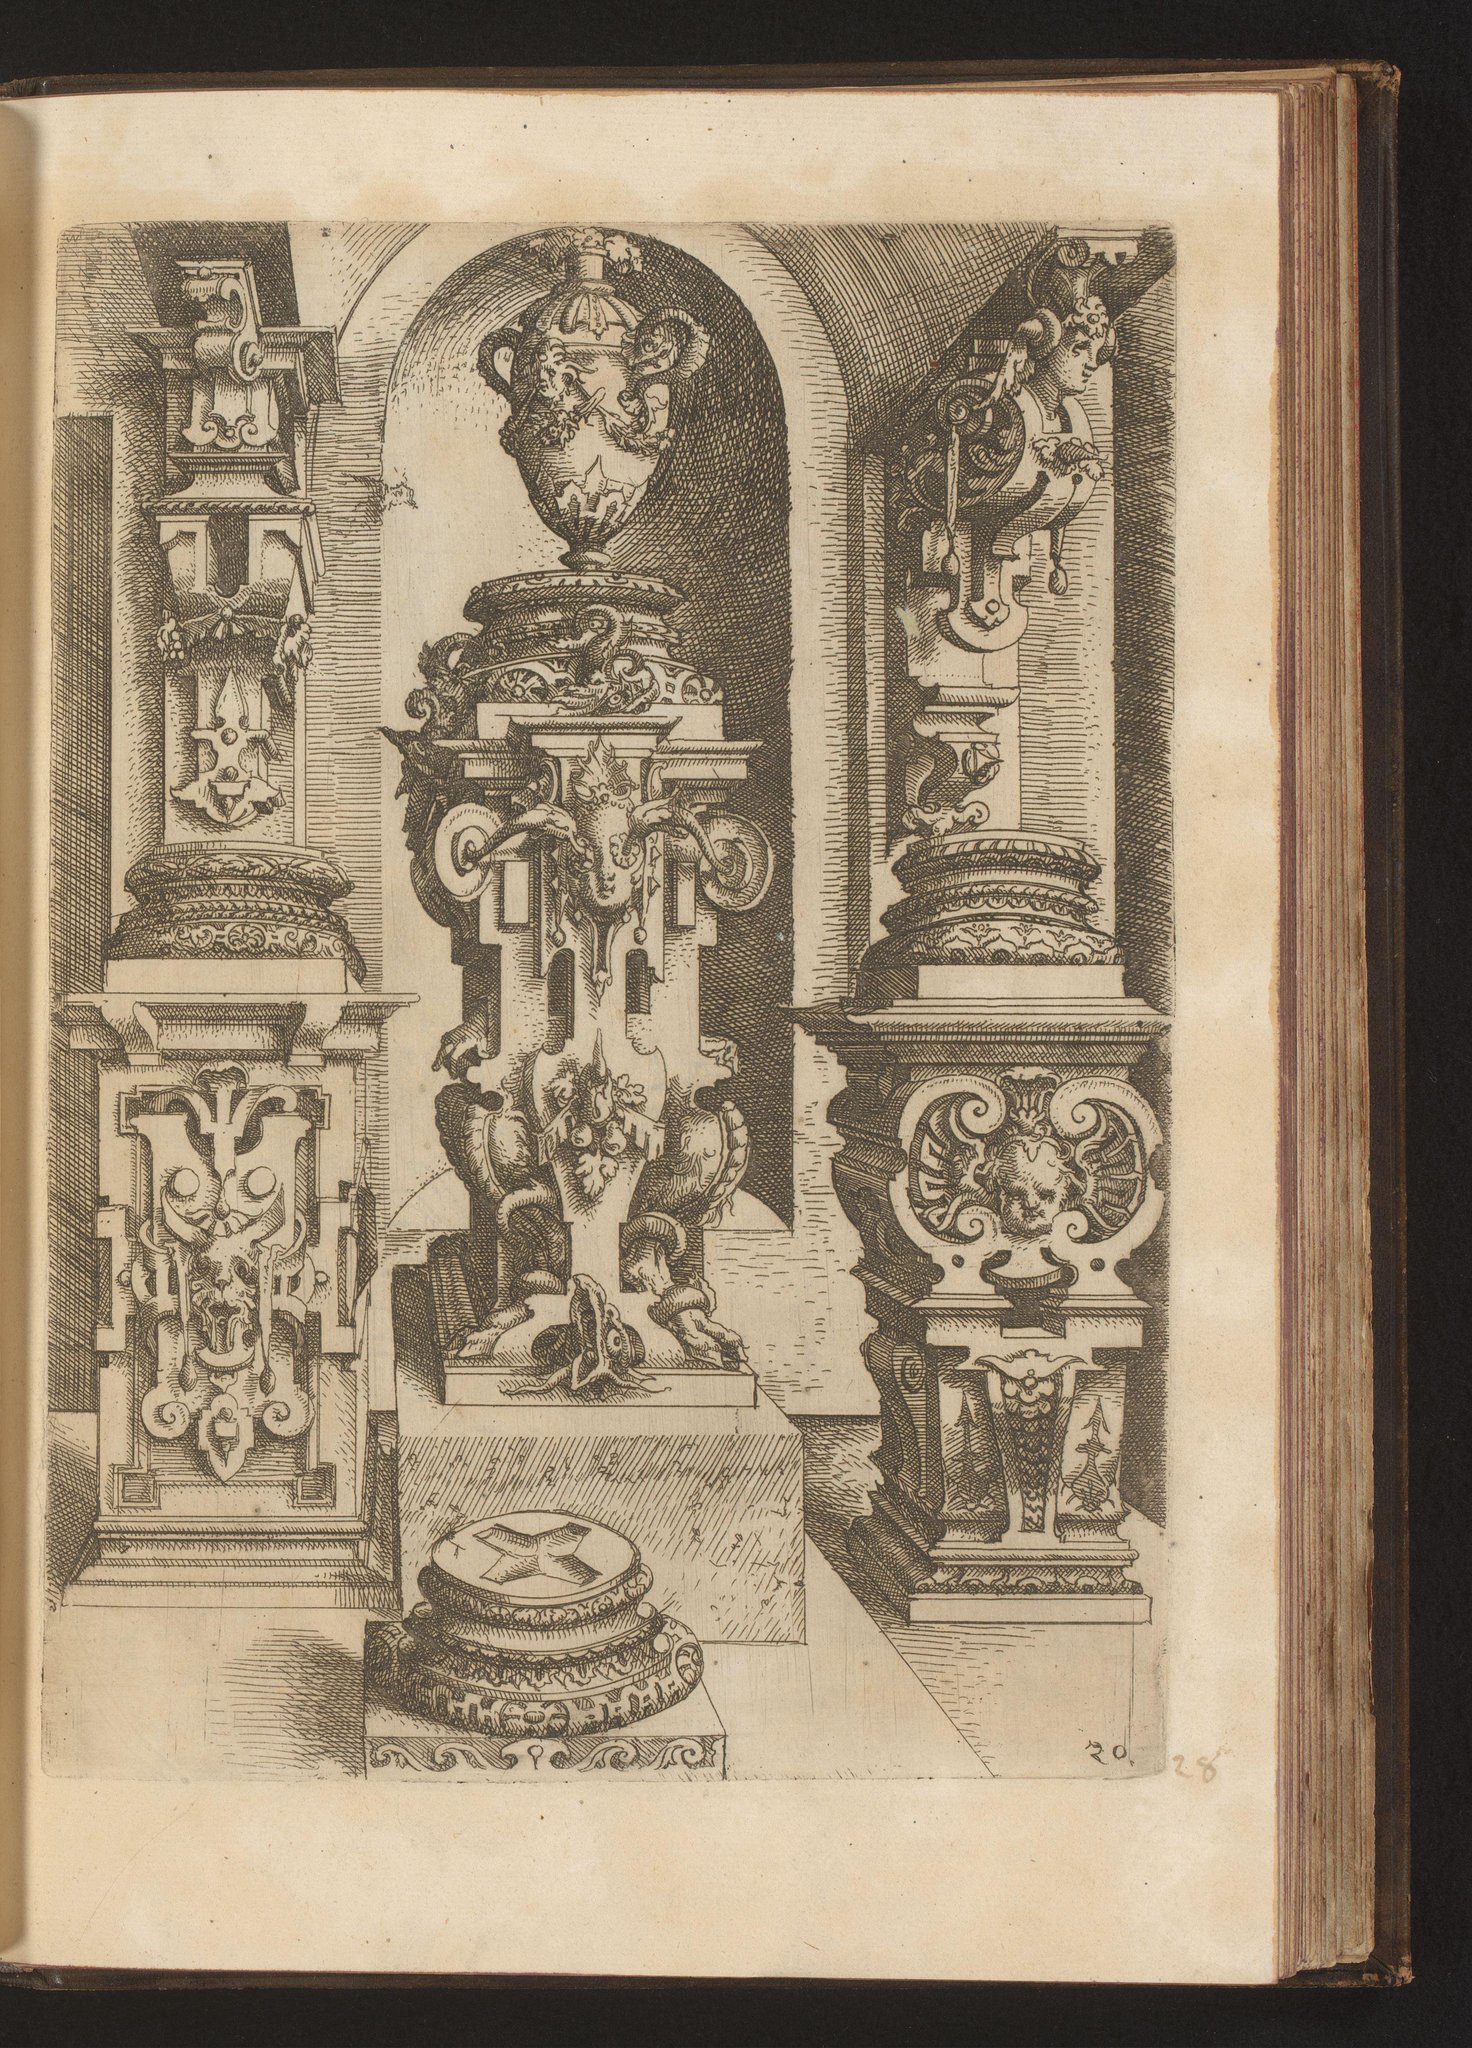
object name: book illustration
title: Architectura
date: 1593-1595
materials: paper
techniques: etching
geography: straatsburg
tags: column, pillar ~ architecture, 'laub- und bandelwerk' ~ ornament, mask, mascaron ~ ornament, other architectural details, base (~ column, pillar), corinthian order ~ architecture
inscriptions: collector's mark: Lugt 2760, collector's mark: Lugt 2228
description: Prent gebruikt in: Dietterlin, Wendel (I). Architectura de quinq[ue] columnarum simmetrica distributione et variis eorundem or namentis: Liber I. Straatsburg: Bernhard Jobin, 1593.